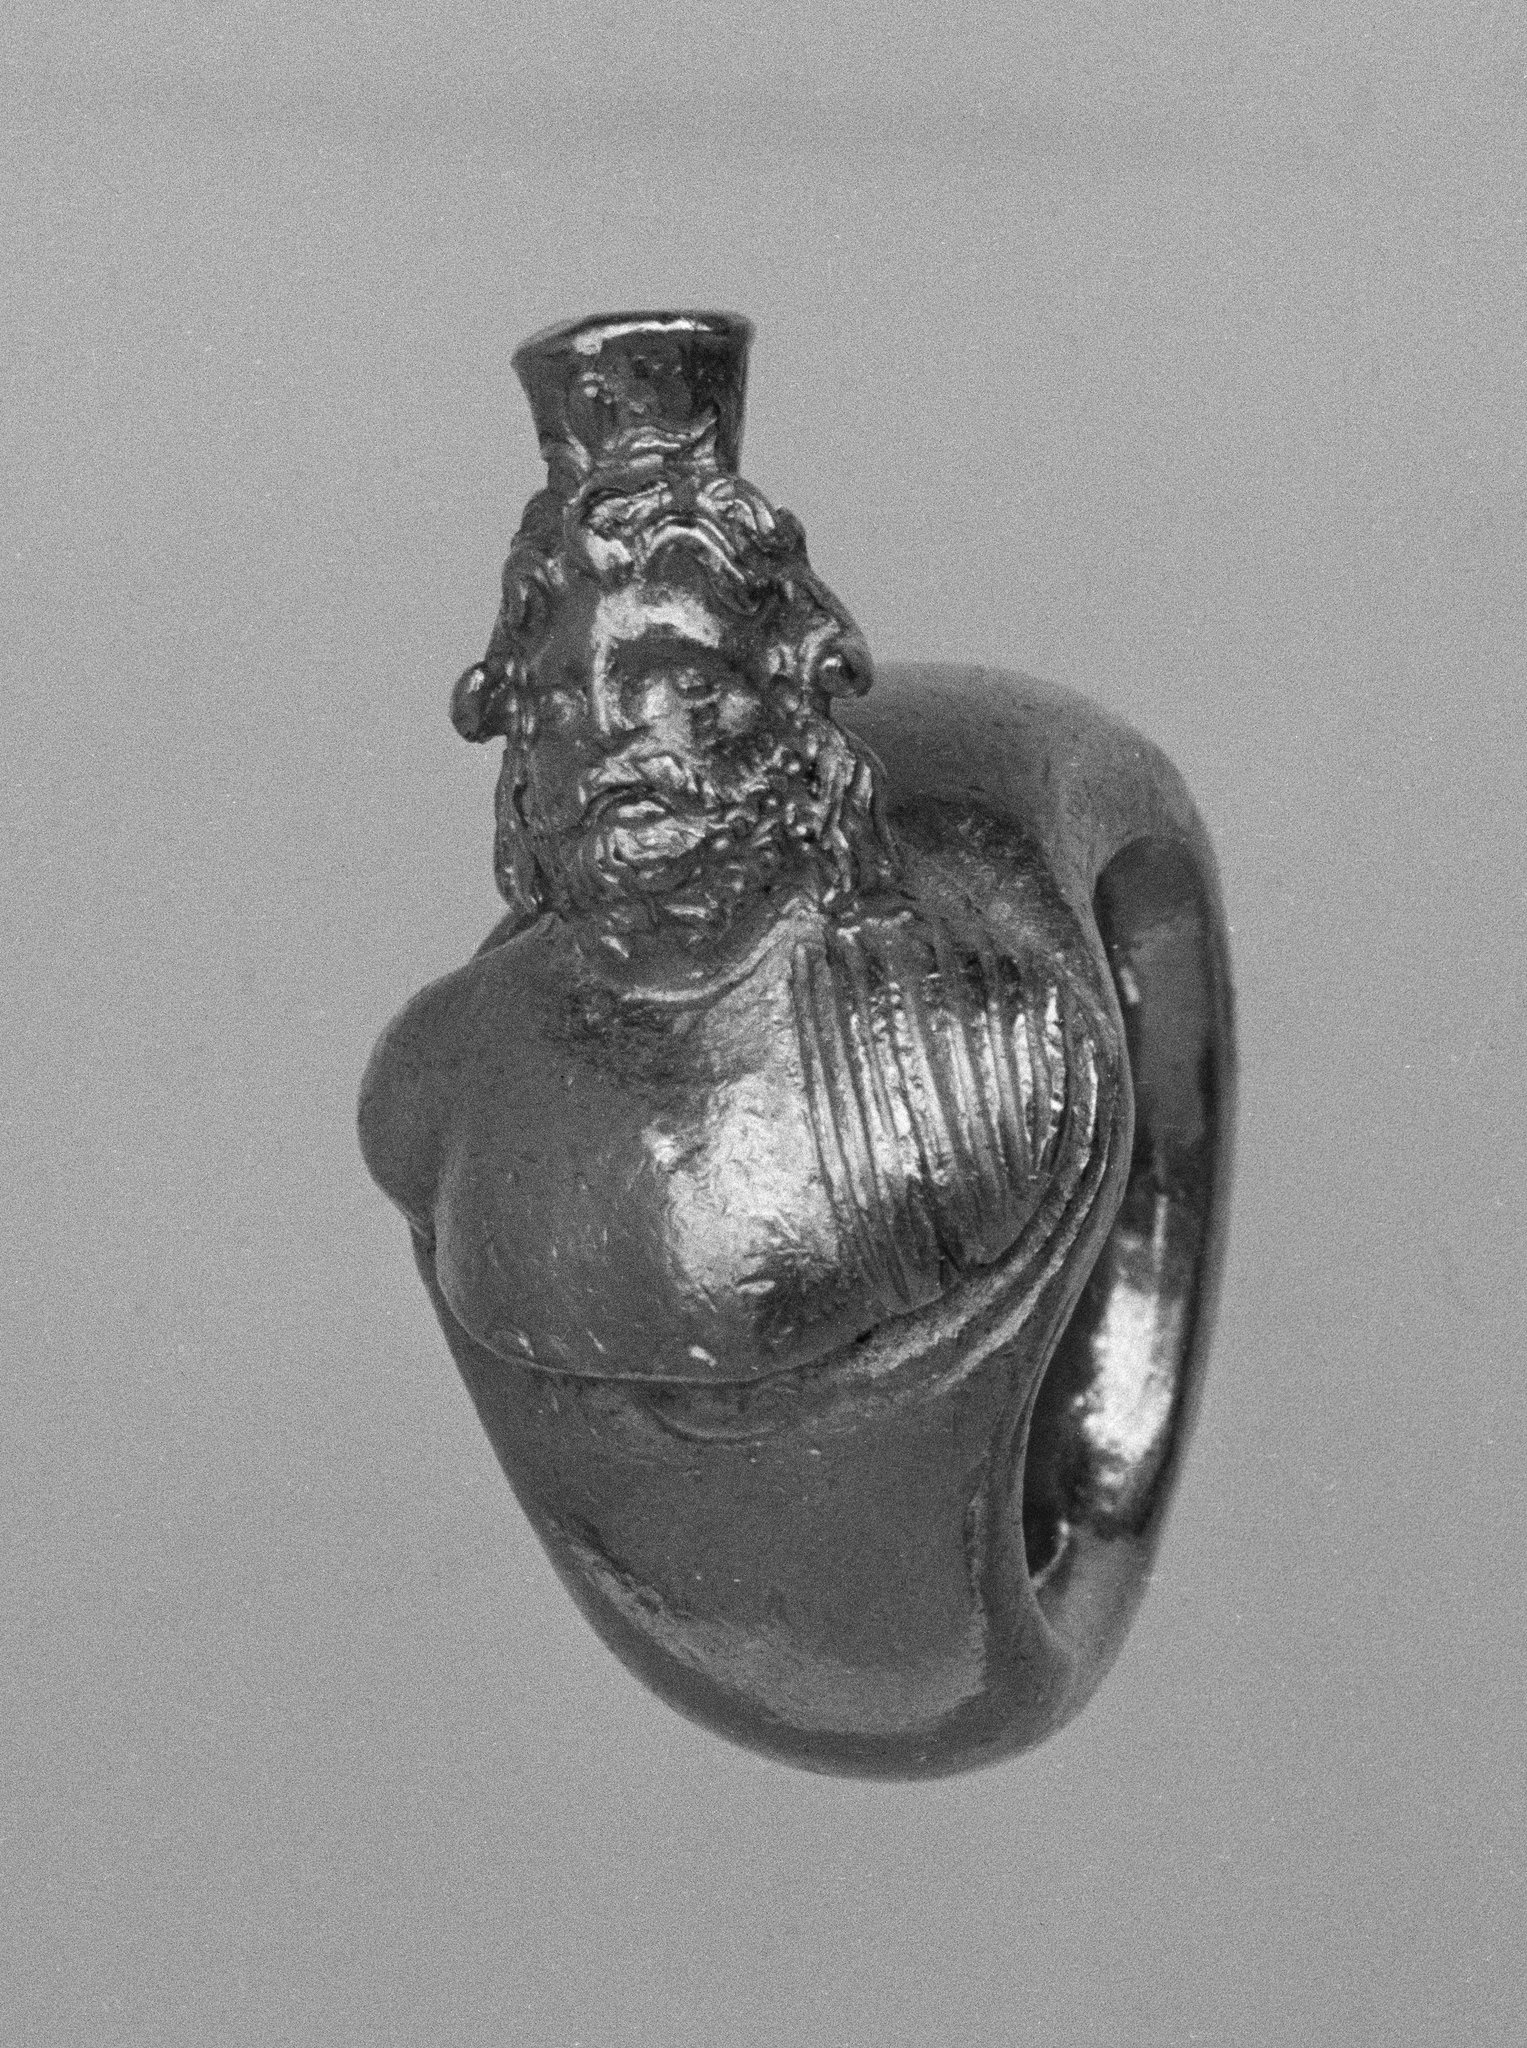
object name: ring, serapis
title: Ring with bezel in the form of a bust of Serapis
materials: gold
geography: egypt